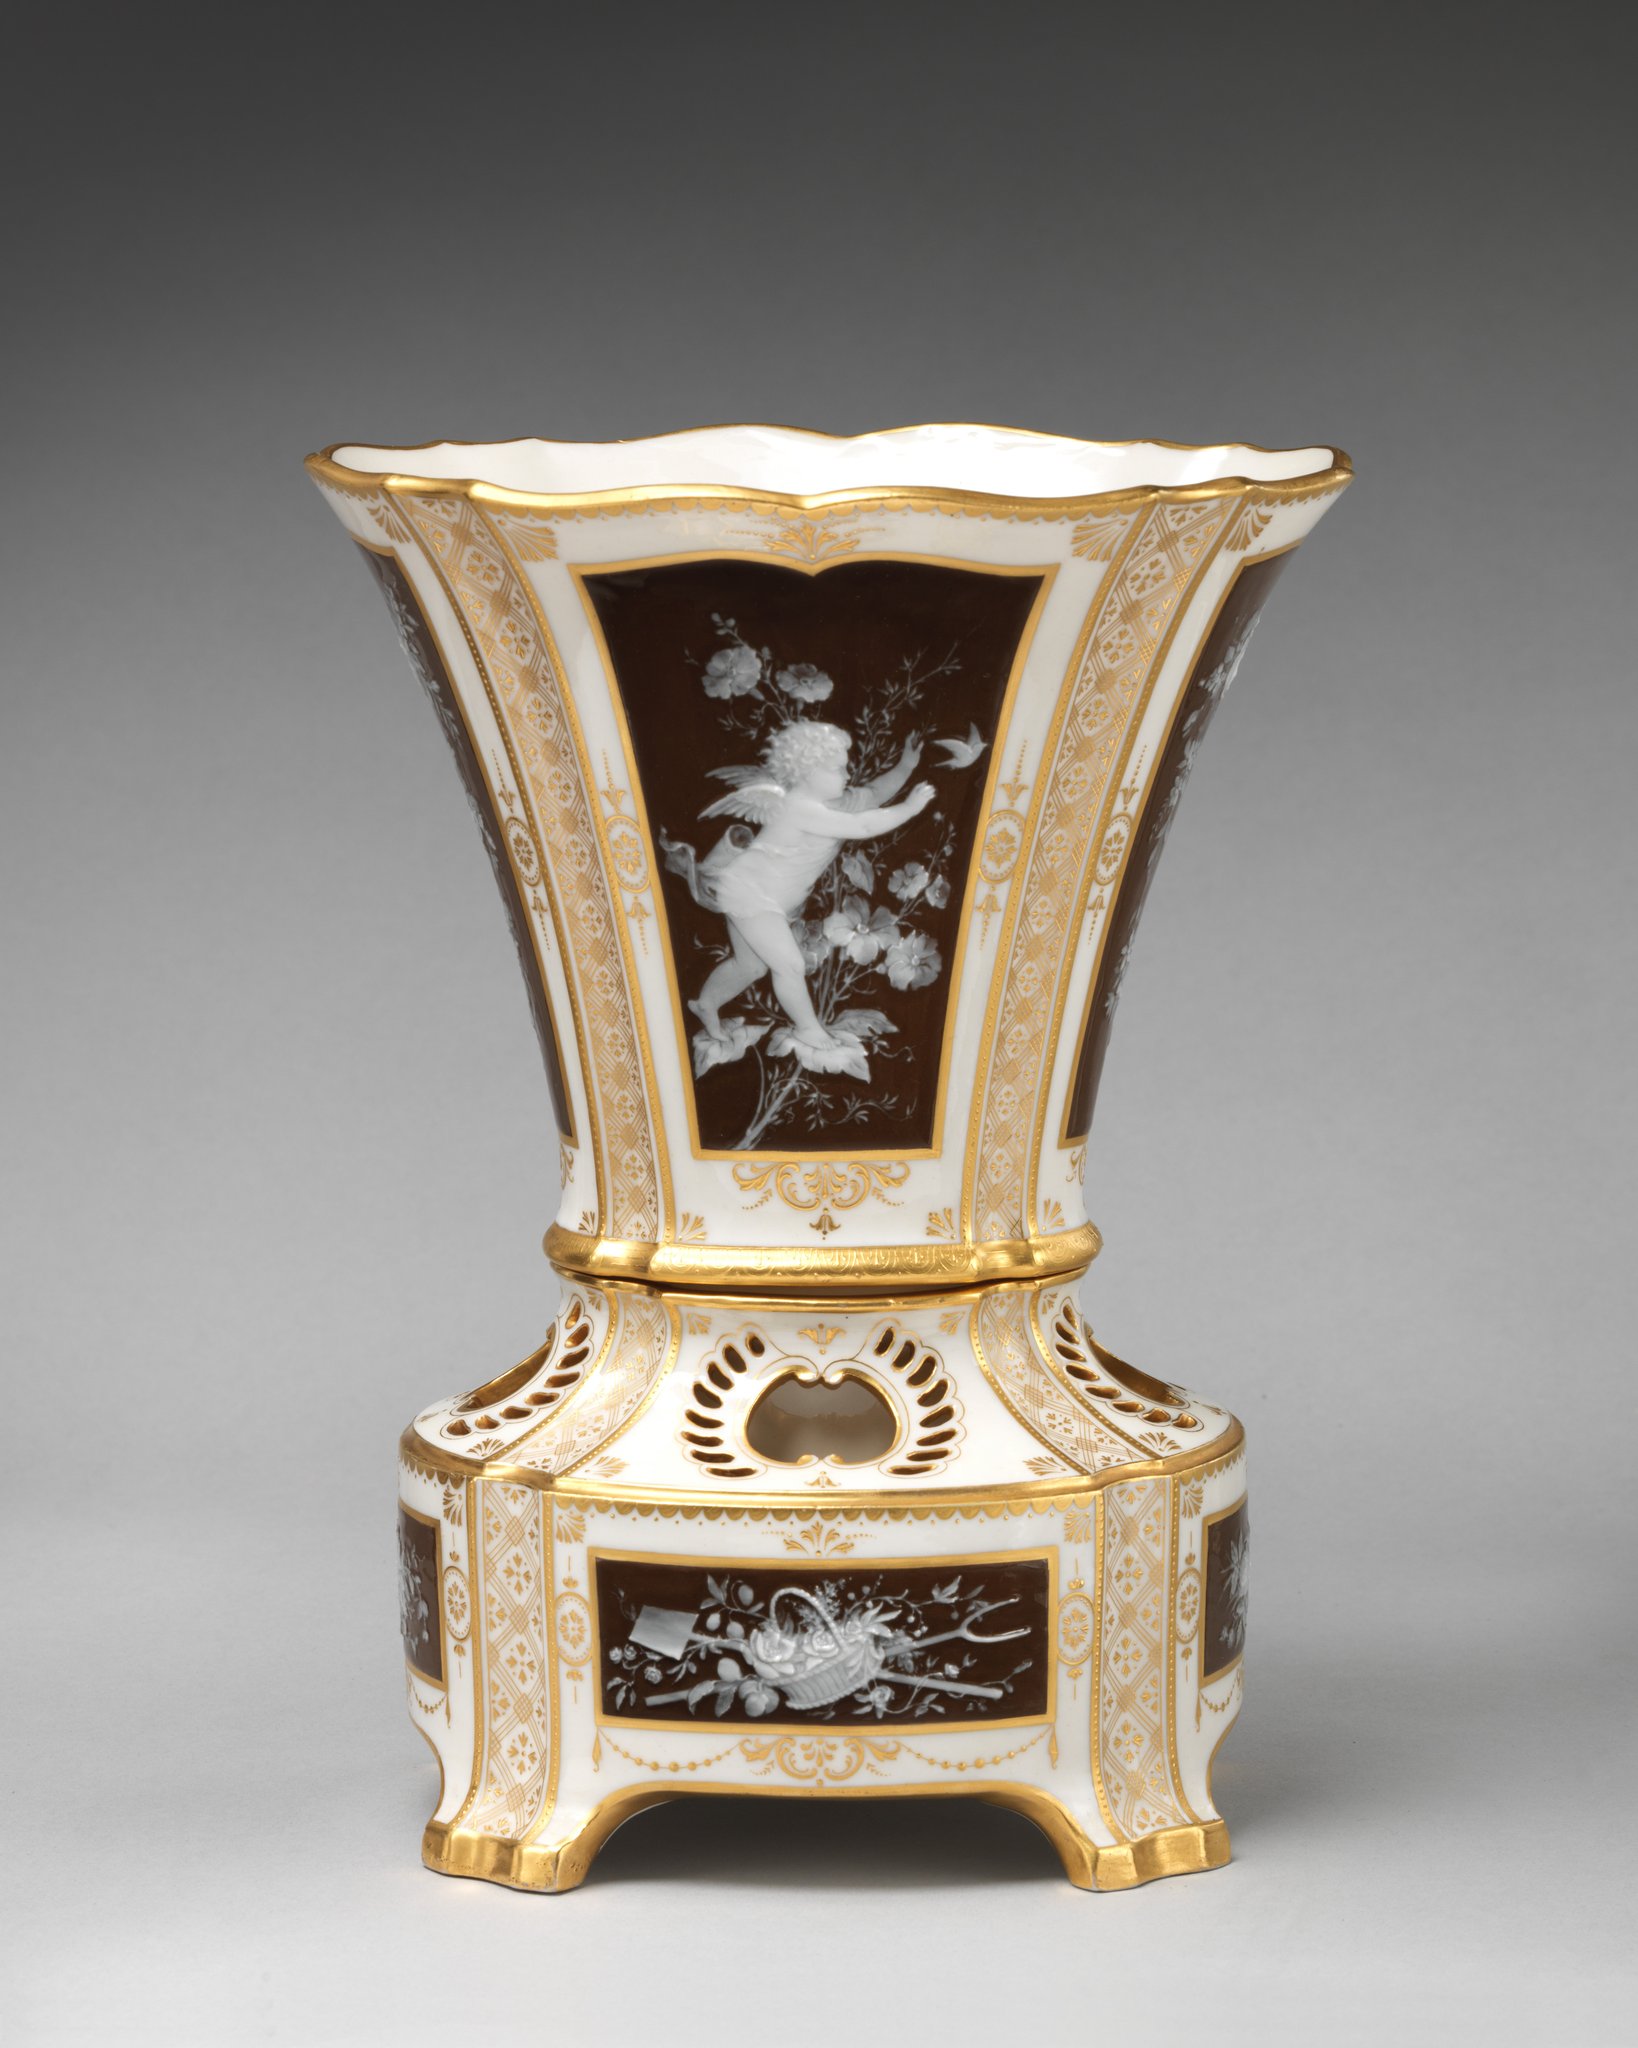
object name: bulb vase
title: Bulb Vase (one of a pair)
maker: minton(s)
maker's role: maker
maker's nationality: british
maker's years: 1793-2001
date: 1889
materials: bone china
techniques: gilding